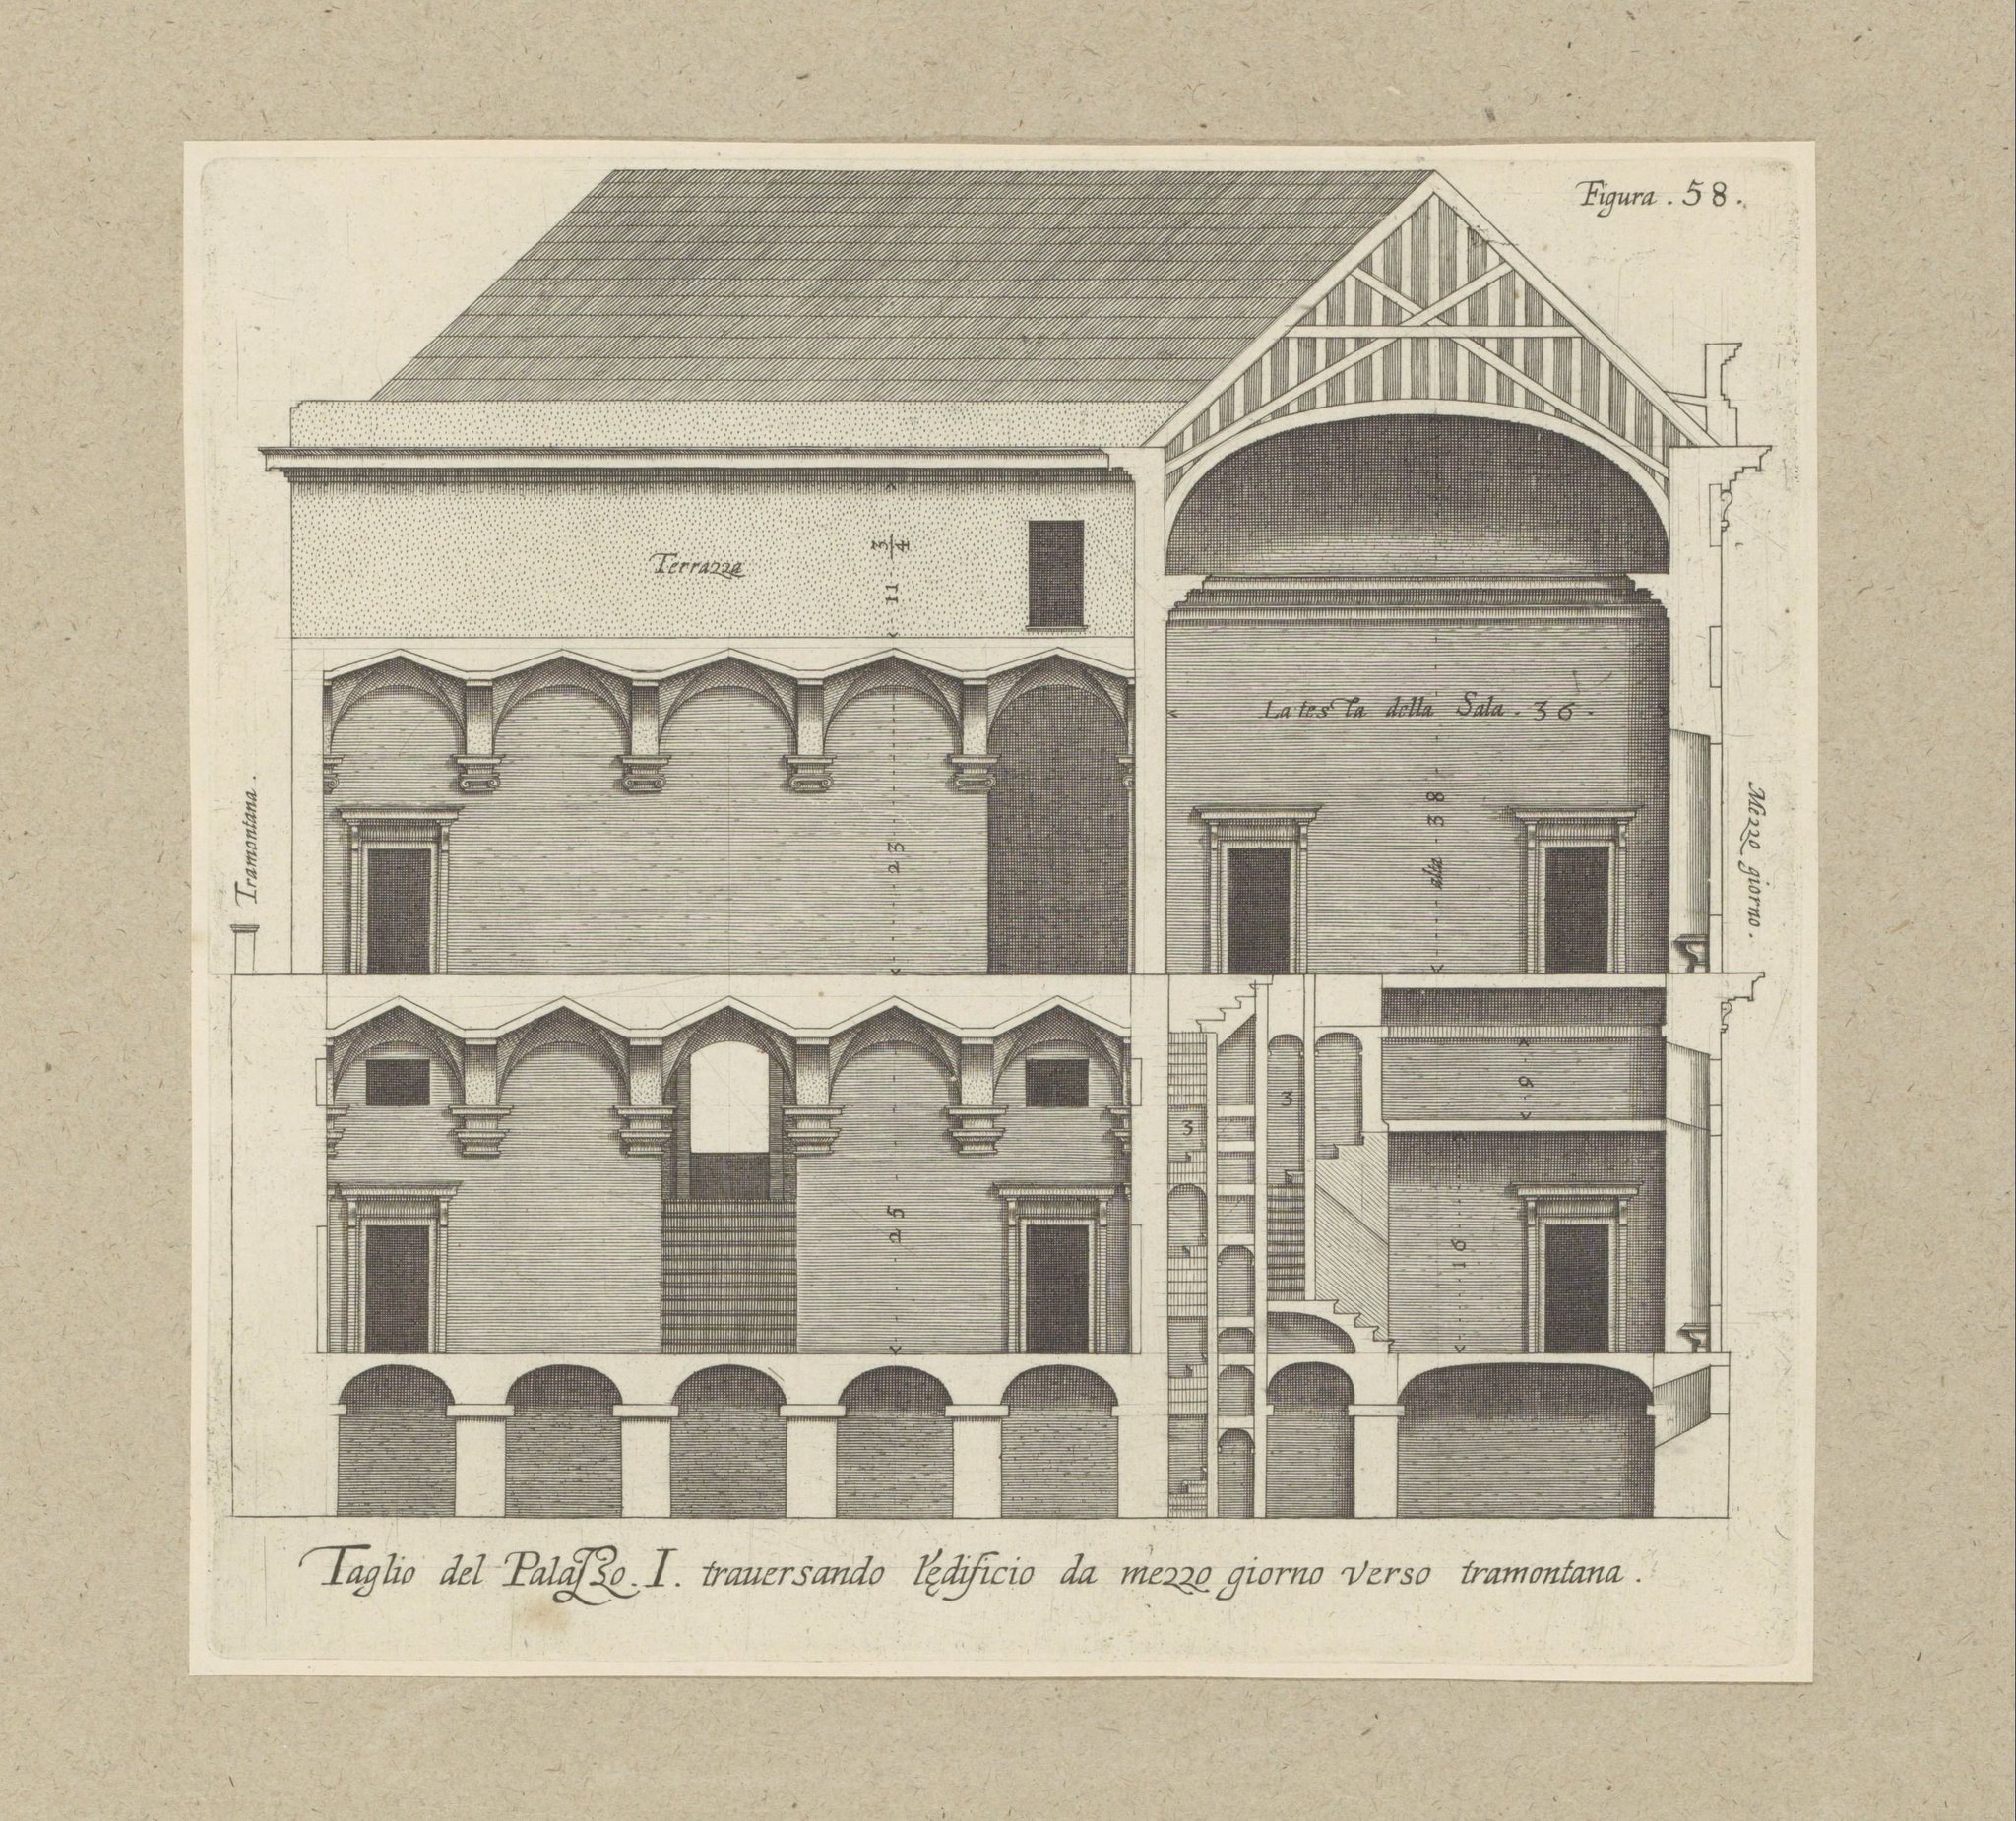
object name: print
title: Langsdoorsnede van het Palazzo Rostan Raggio te Genua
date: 1622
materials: paper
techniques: engraving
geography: antwerp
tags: hôtel, i.e. small palace in city - aa - civic architecture: inside, section ~ architectural design or model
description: Deze prent maakt deel uit van een album.